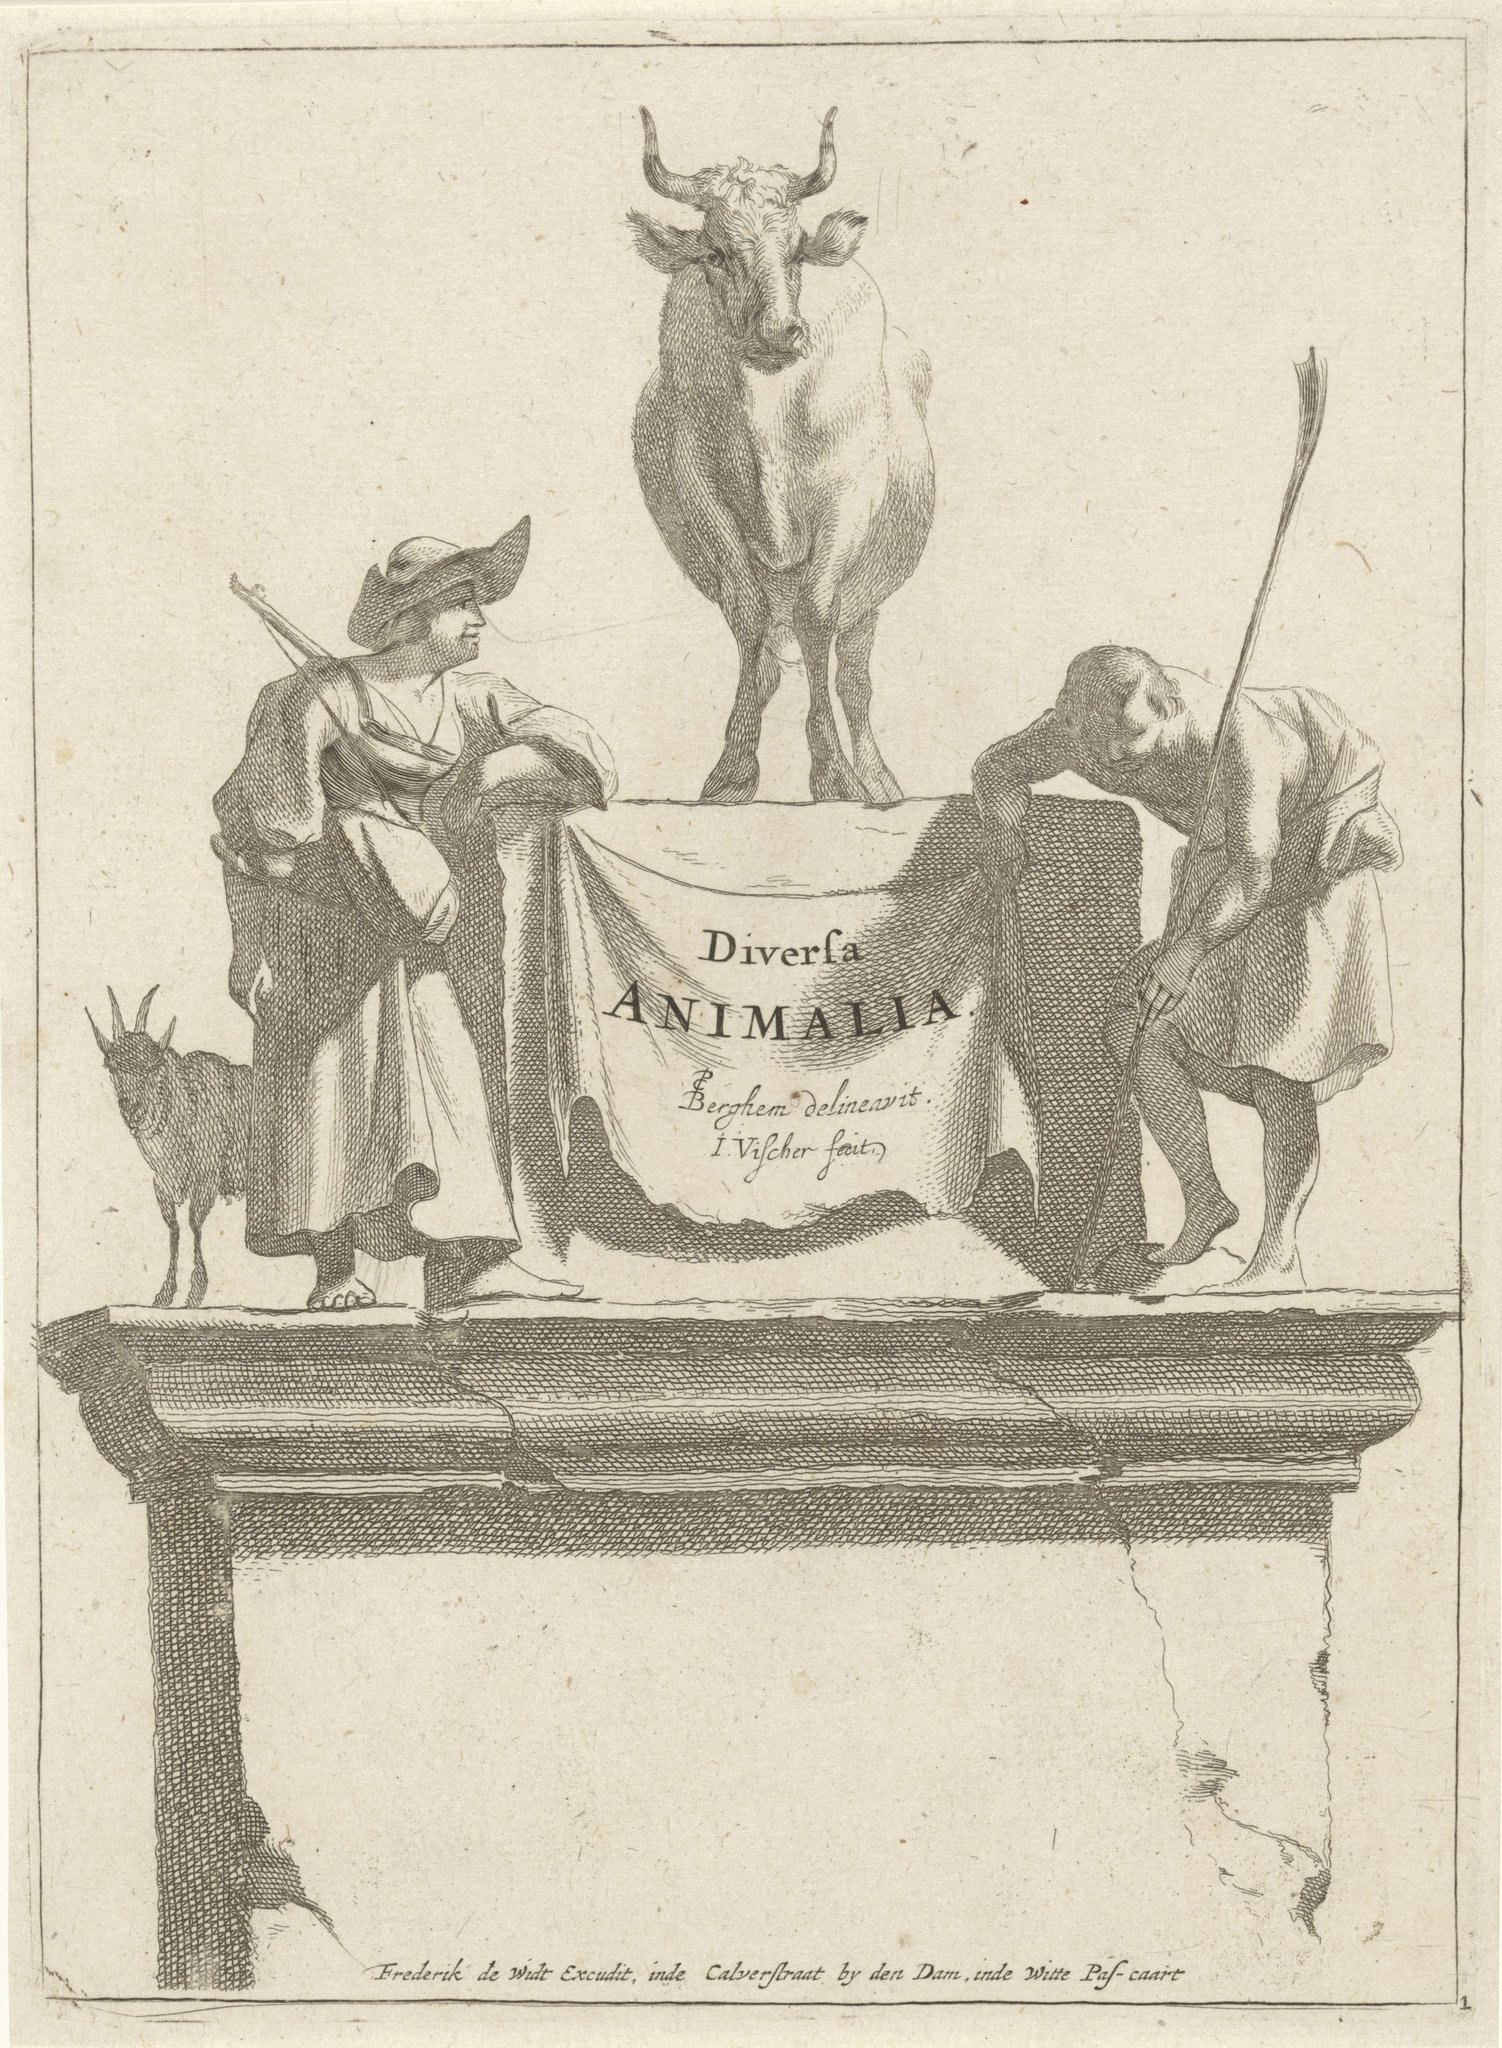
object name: print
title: Landschappen met dieren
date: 1643-1706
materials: paper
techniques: etching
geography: northern netherlands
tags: cow, herding, herdsman, herdswoman, shepherd, shepherdess, cowherd, etc.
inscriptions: collector's mark: Lugt 2228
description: Titelprent voor de 12-delige serie 'Diversa Animalia' met prenten van verschillende dieren in landschappen. De titel wordt geflankeerd door een herderin en een herder. Op de titel staat een koe.